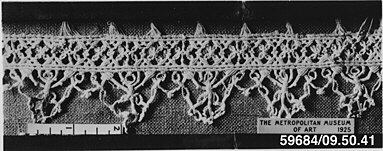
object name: macrame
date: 1501-1700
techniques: lace